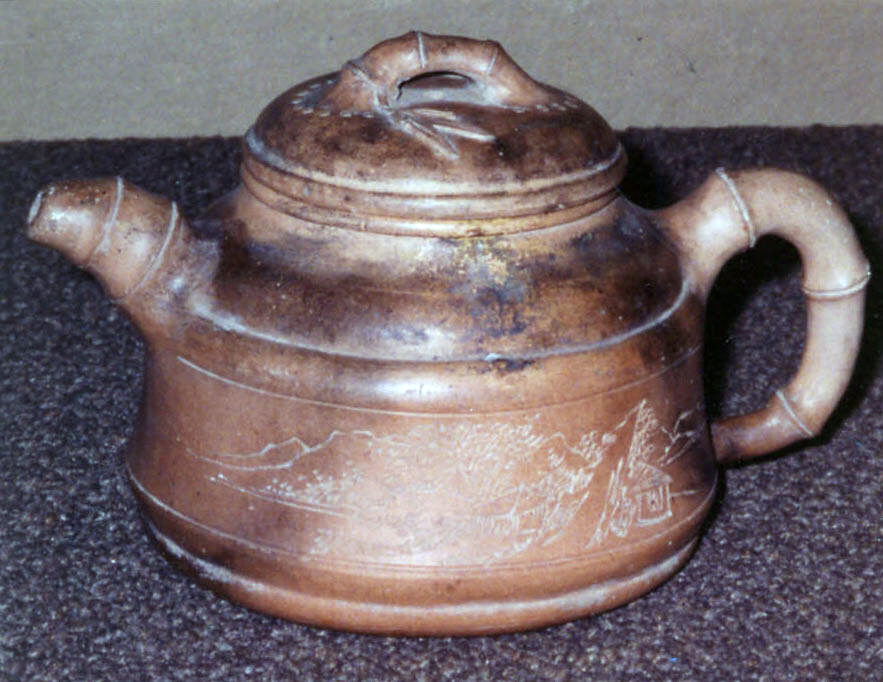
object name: teapot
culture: chinese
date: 1901-2000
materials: stoneware